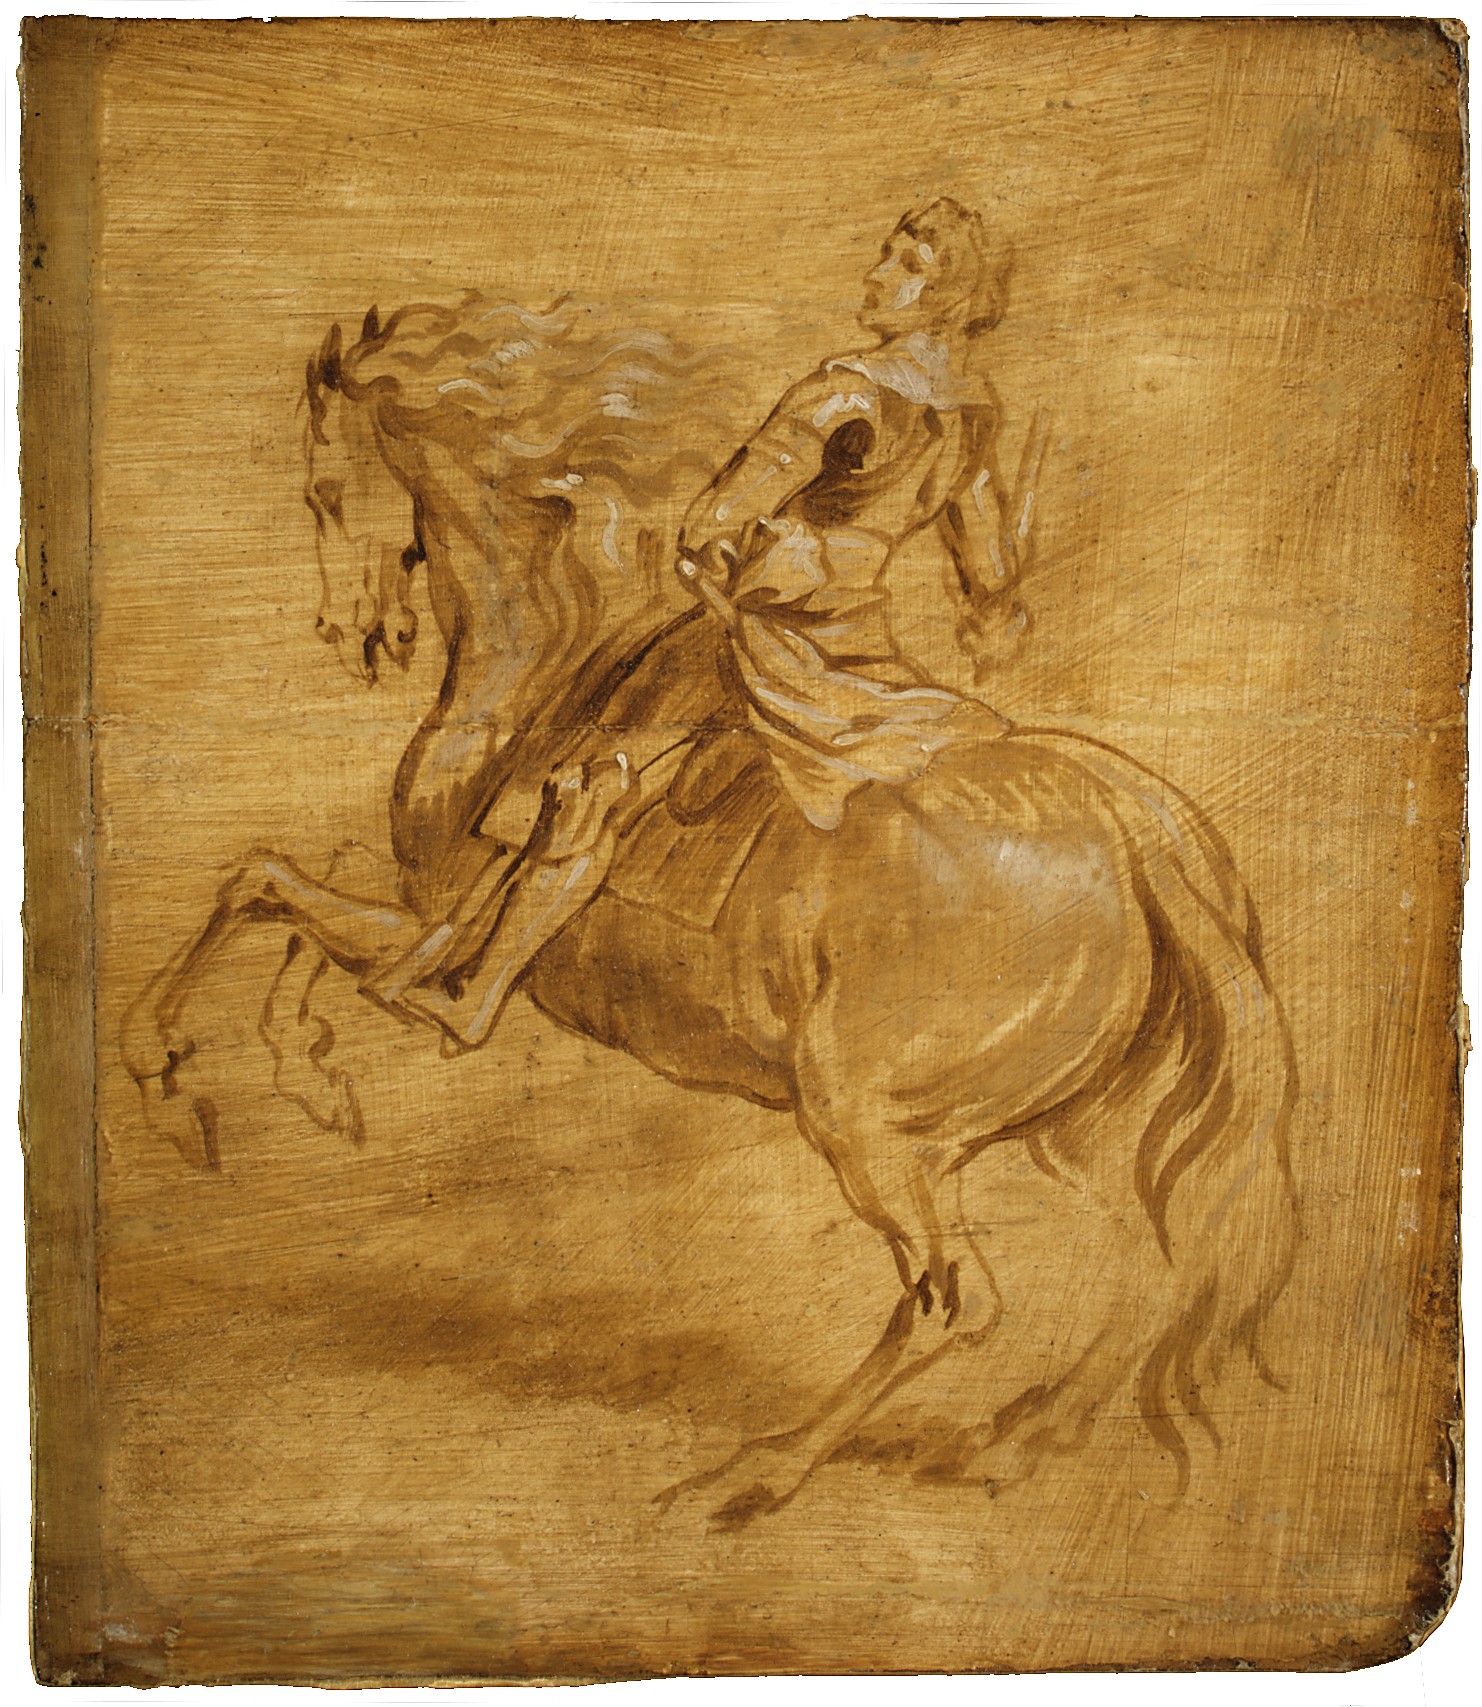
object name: painting, monochrome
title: A Man Riding a Horse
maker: anthony van dyck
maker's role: artist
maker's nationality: flemish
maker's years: 1599-1641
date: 1630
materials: oil, wood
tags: men,horses